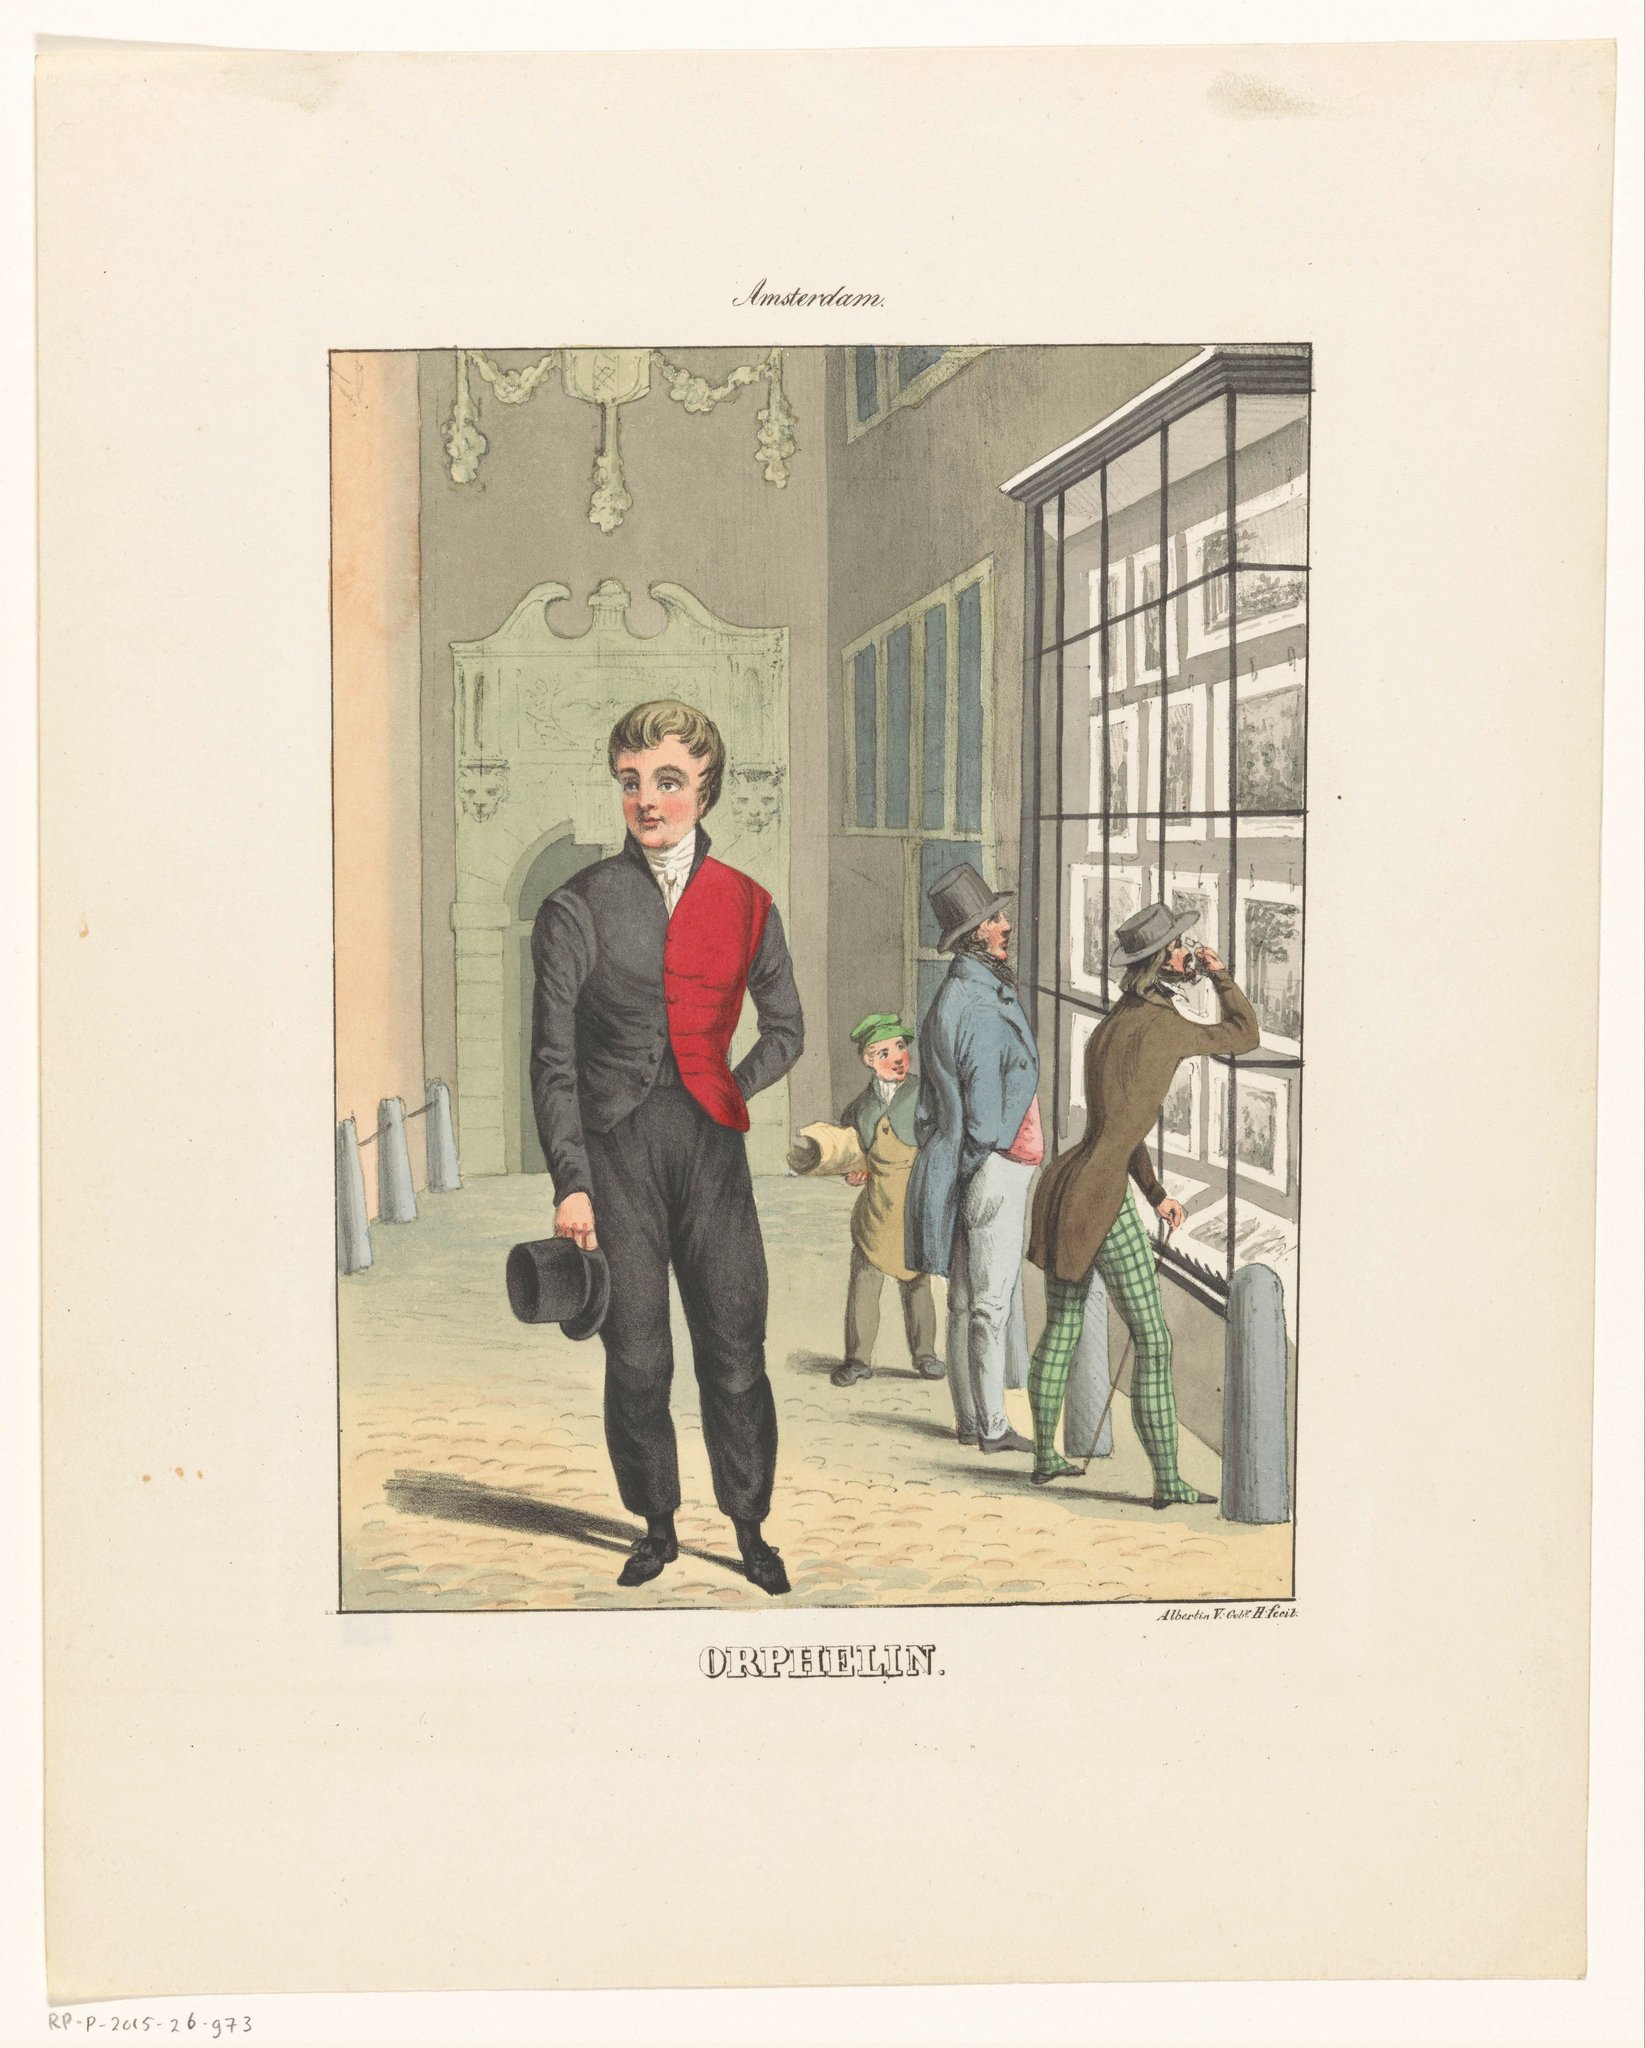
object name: print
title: Weesjongen voor de poort van het Burgerweeshuis te Amsterdam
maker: albertine v.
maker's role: lithograaf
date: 1825-1875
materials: paper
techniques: hand coloring, lithograph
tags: art dealer, orphans, shop-window, show-window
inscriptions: collector's mark: Lugt 4780, collector's mark: Lugt 2228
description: Achter de weesjongen bekijken twee mannen en een jongen de etalage van kunsthandel Frans Buffa & Zonen.